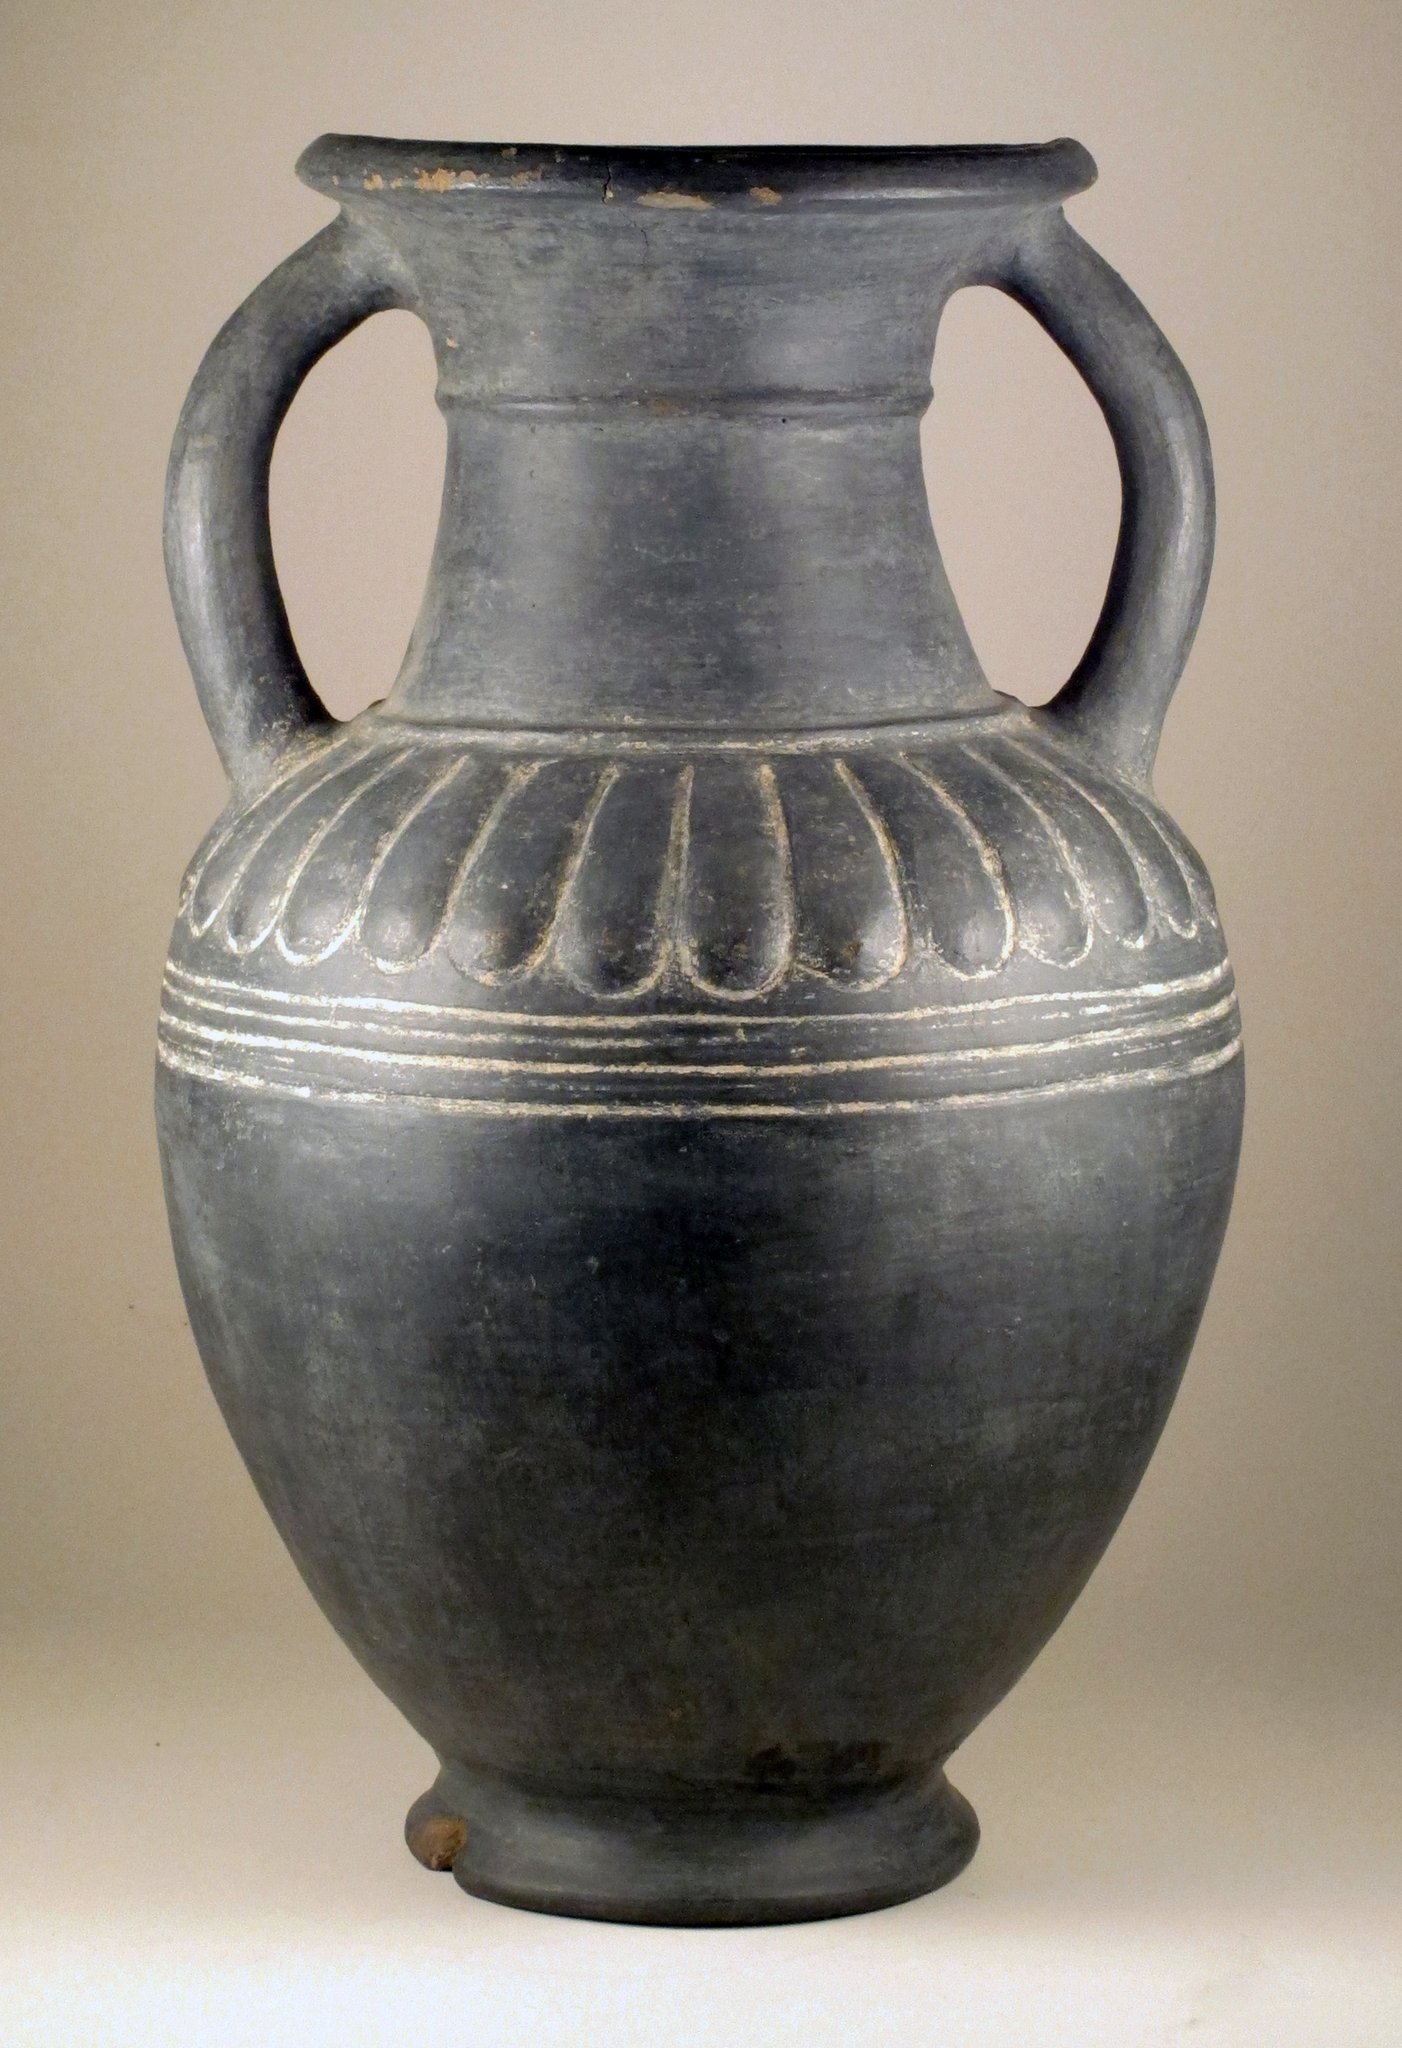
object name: amphora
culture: etruscan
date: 567-535 BCE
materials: terracotta